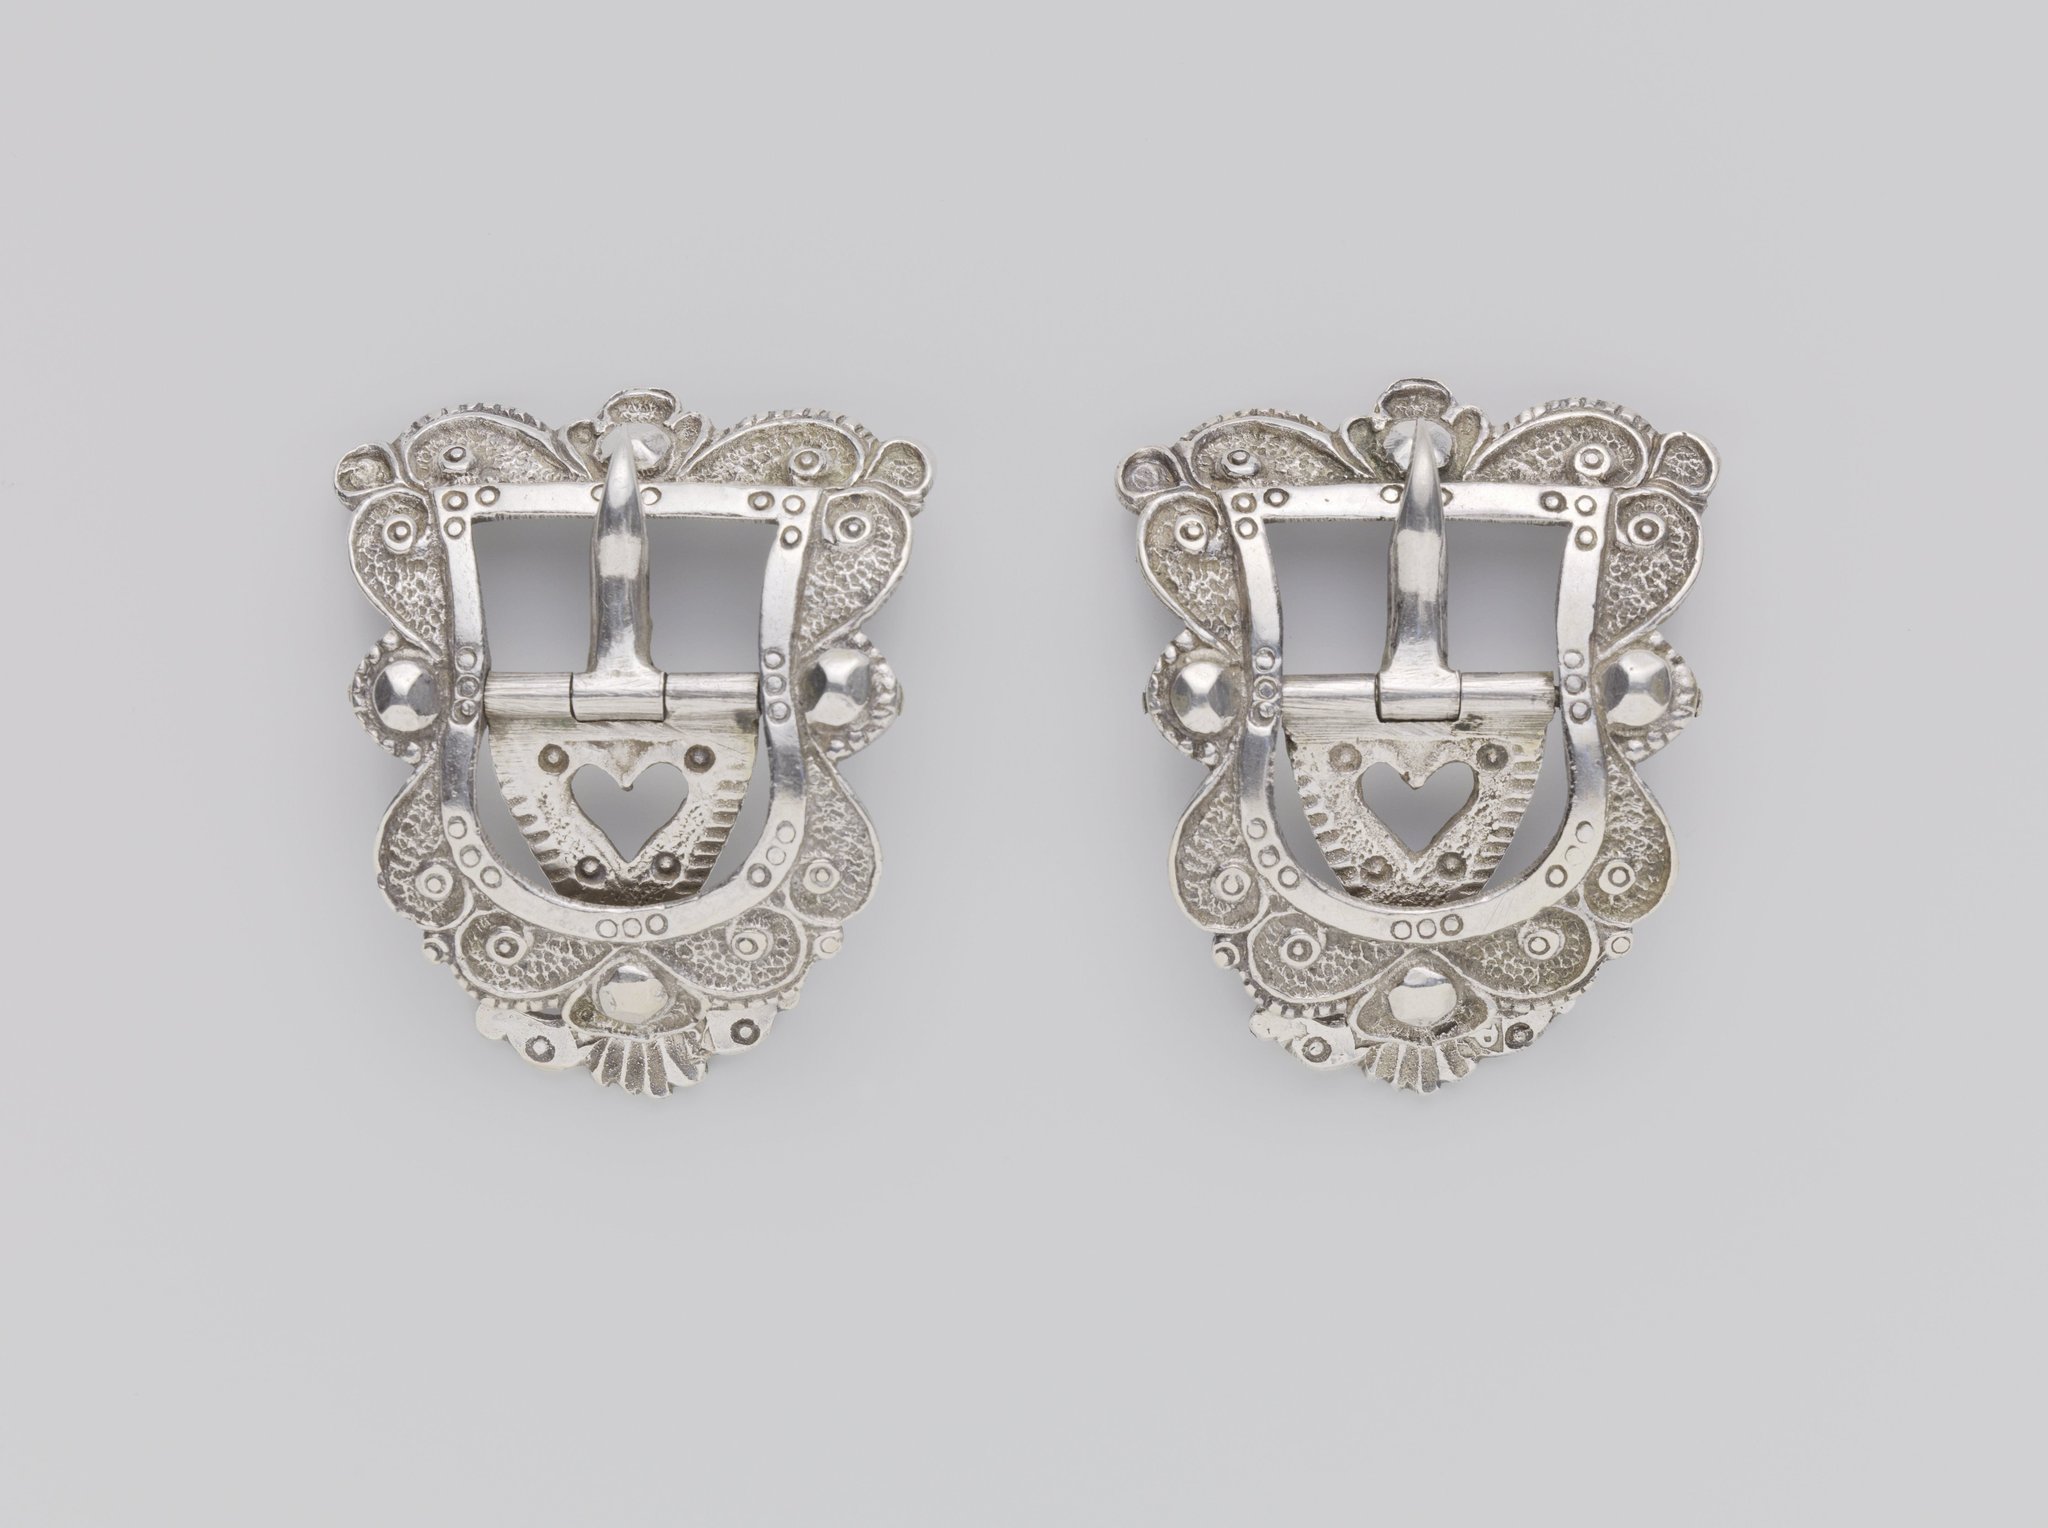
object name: jewellery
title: Paar ceintuurgespen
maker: Anonymous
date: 1788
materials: silver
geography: schoonhoven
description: Een paar zilveren ceintuurgespen. Asymmetrisch van vorm en versierd met krullen.